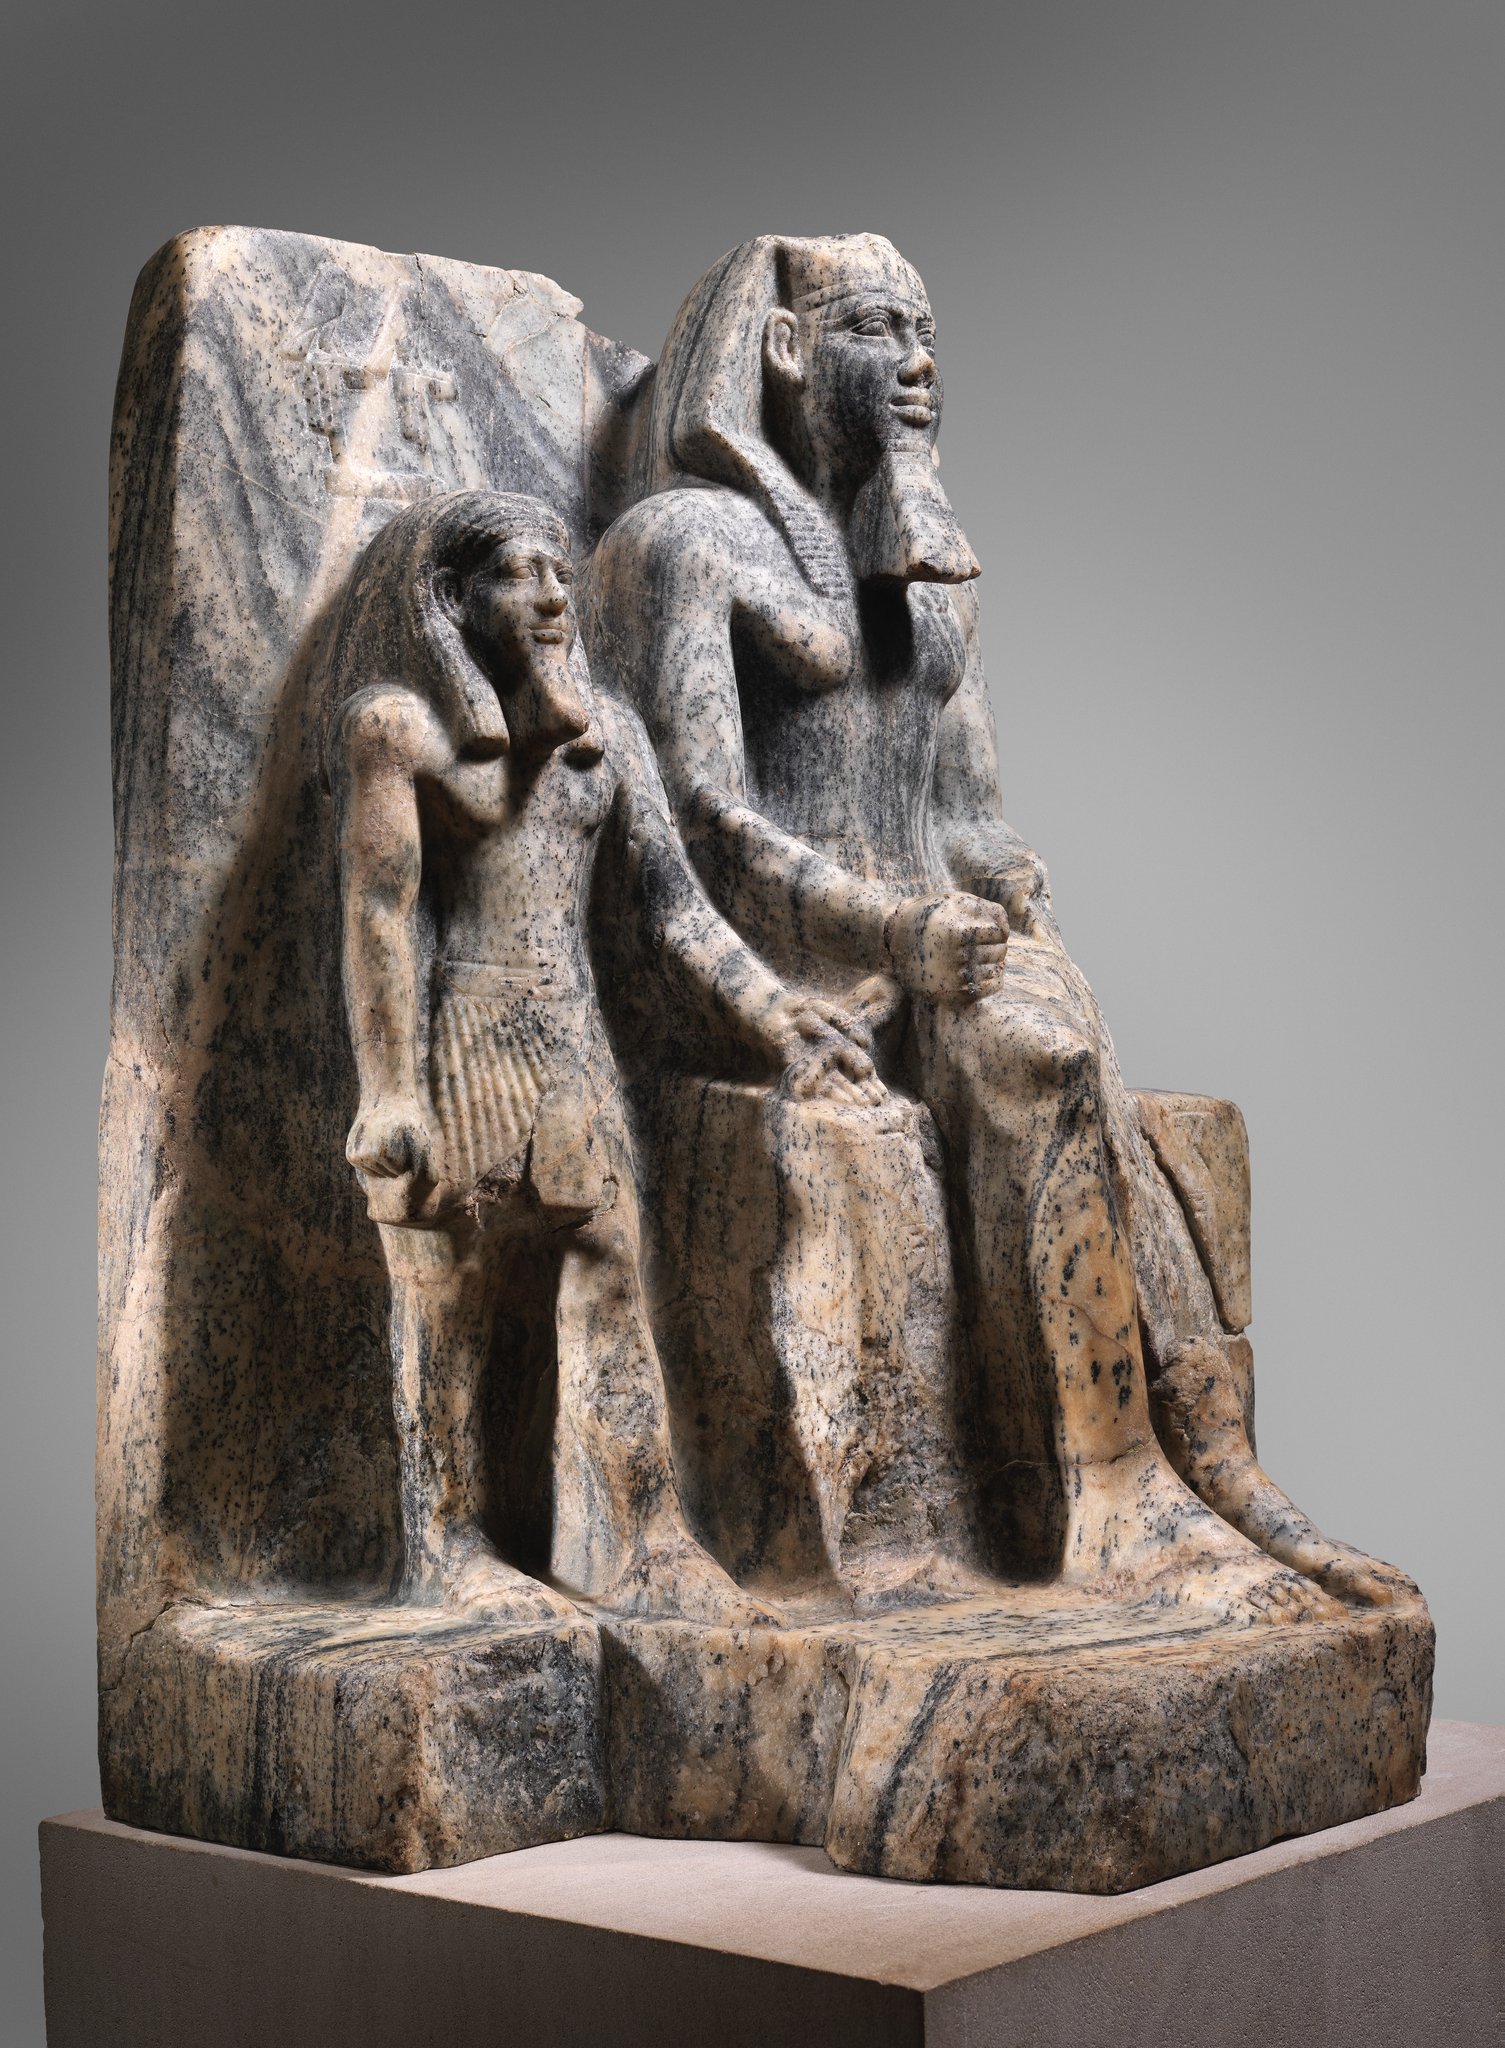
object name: statue group, king sahure, nome god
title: King Sahure Accompanied by a Divine Figure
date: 2458-2446 BCE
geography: egypt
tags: kings,men